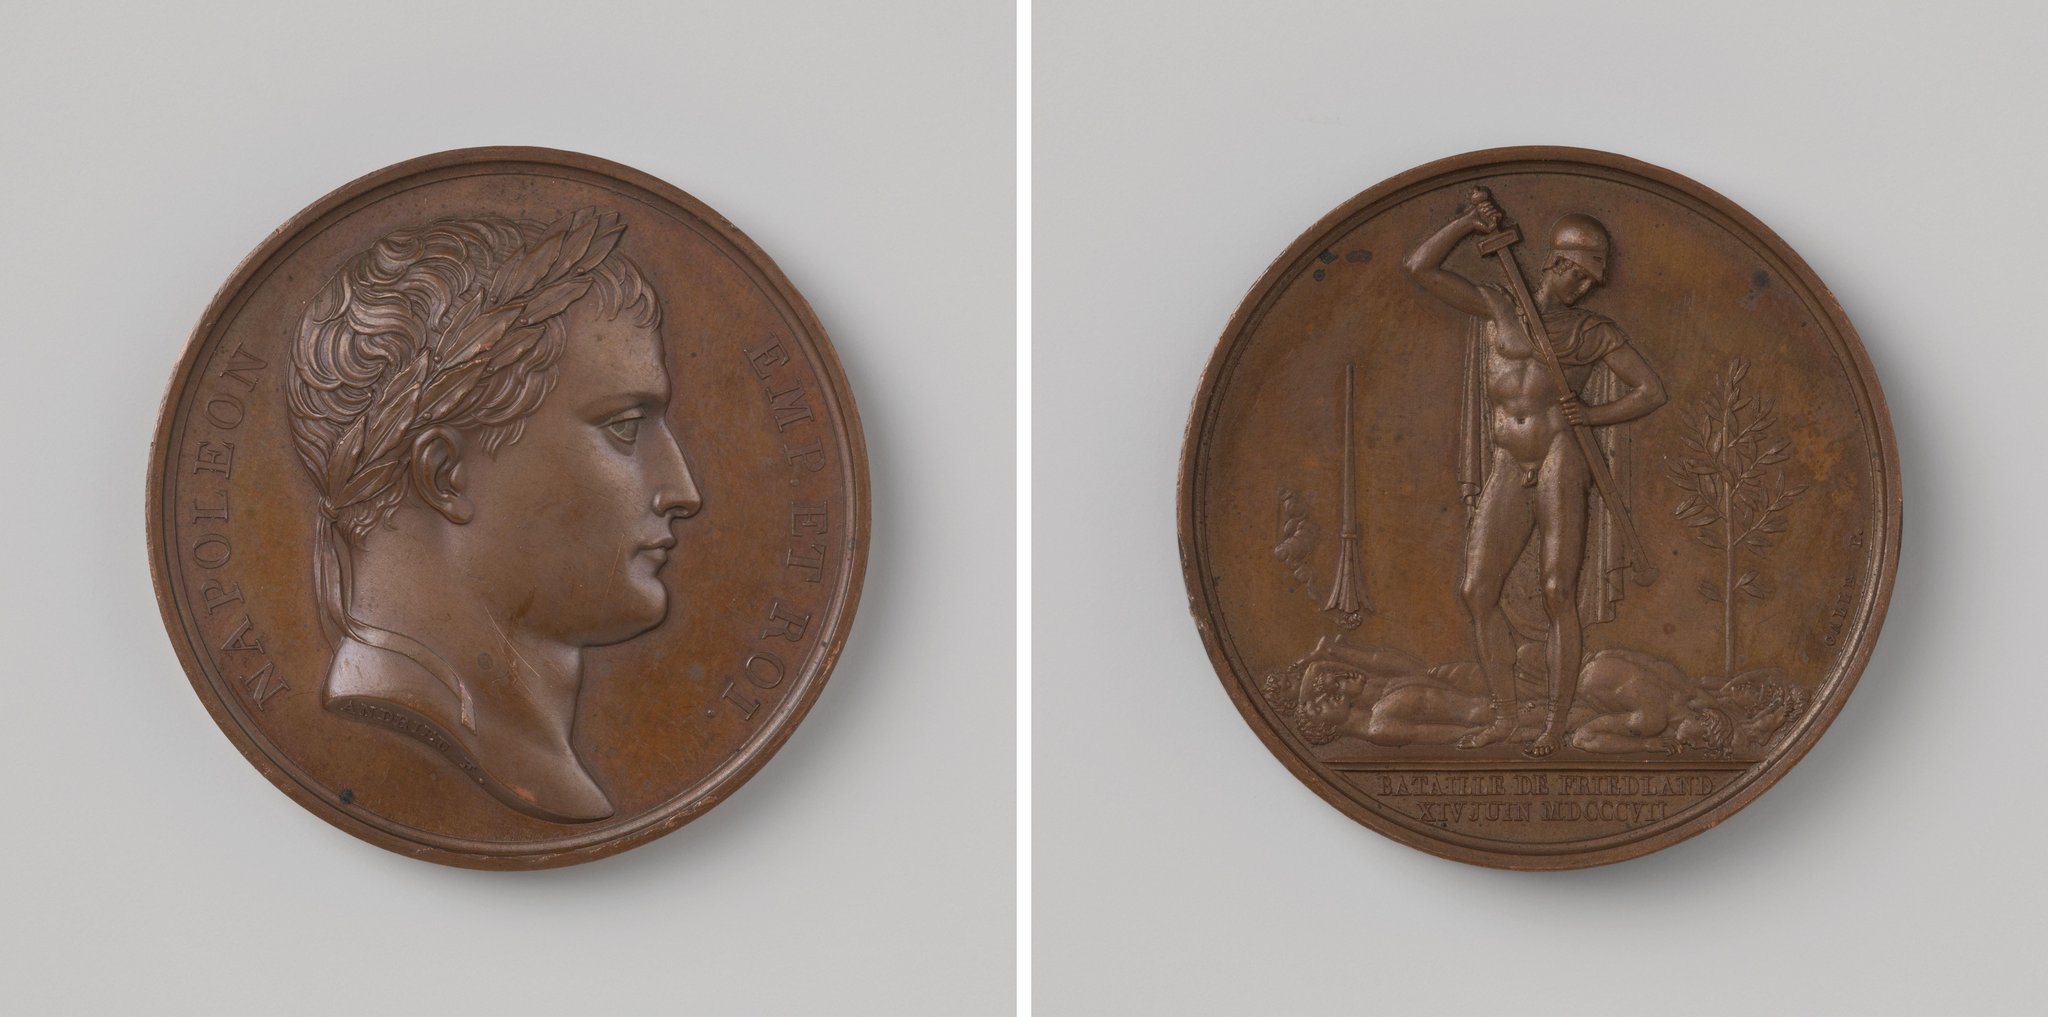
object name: history medal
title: Overwinning bij Friedland, ter ere van Napoleon I Bonaparte, keizer der Fransen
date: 1807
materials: bronze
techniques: striking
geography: paris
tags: napoleon i (emperor of the french)